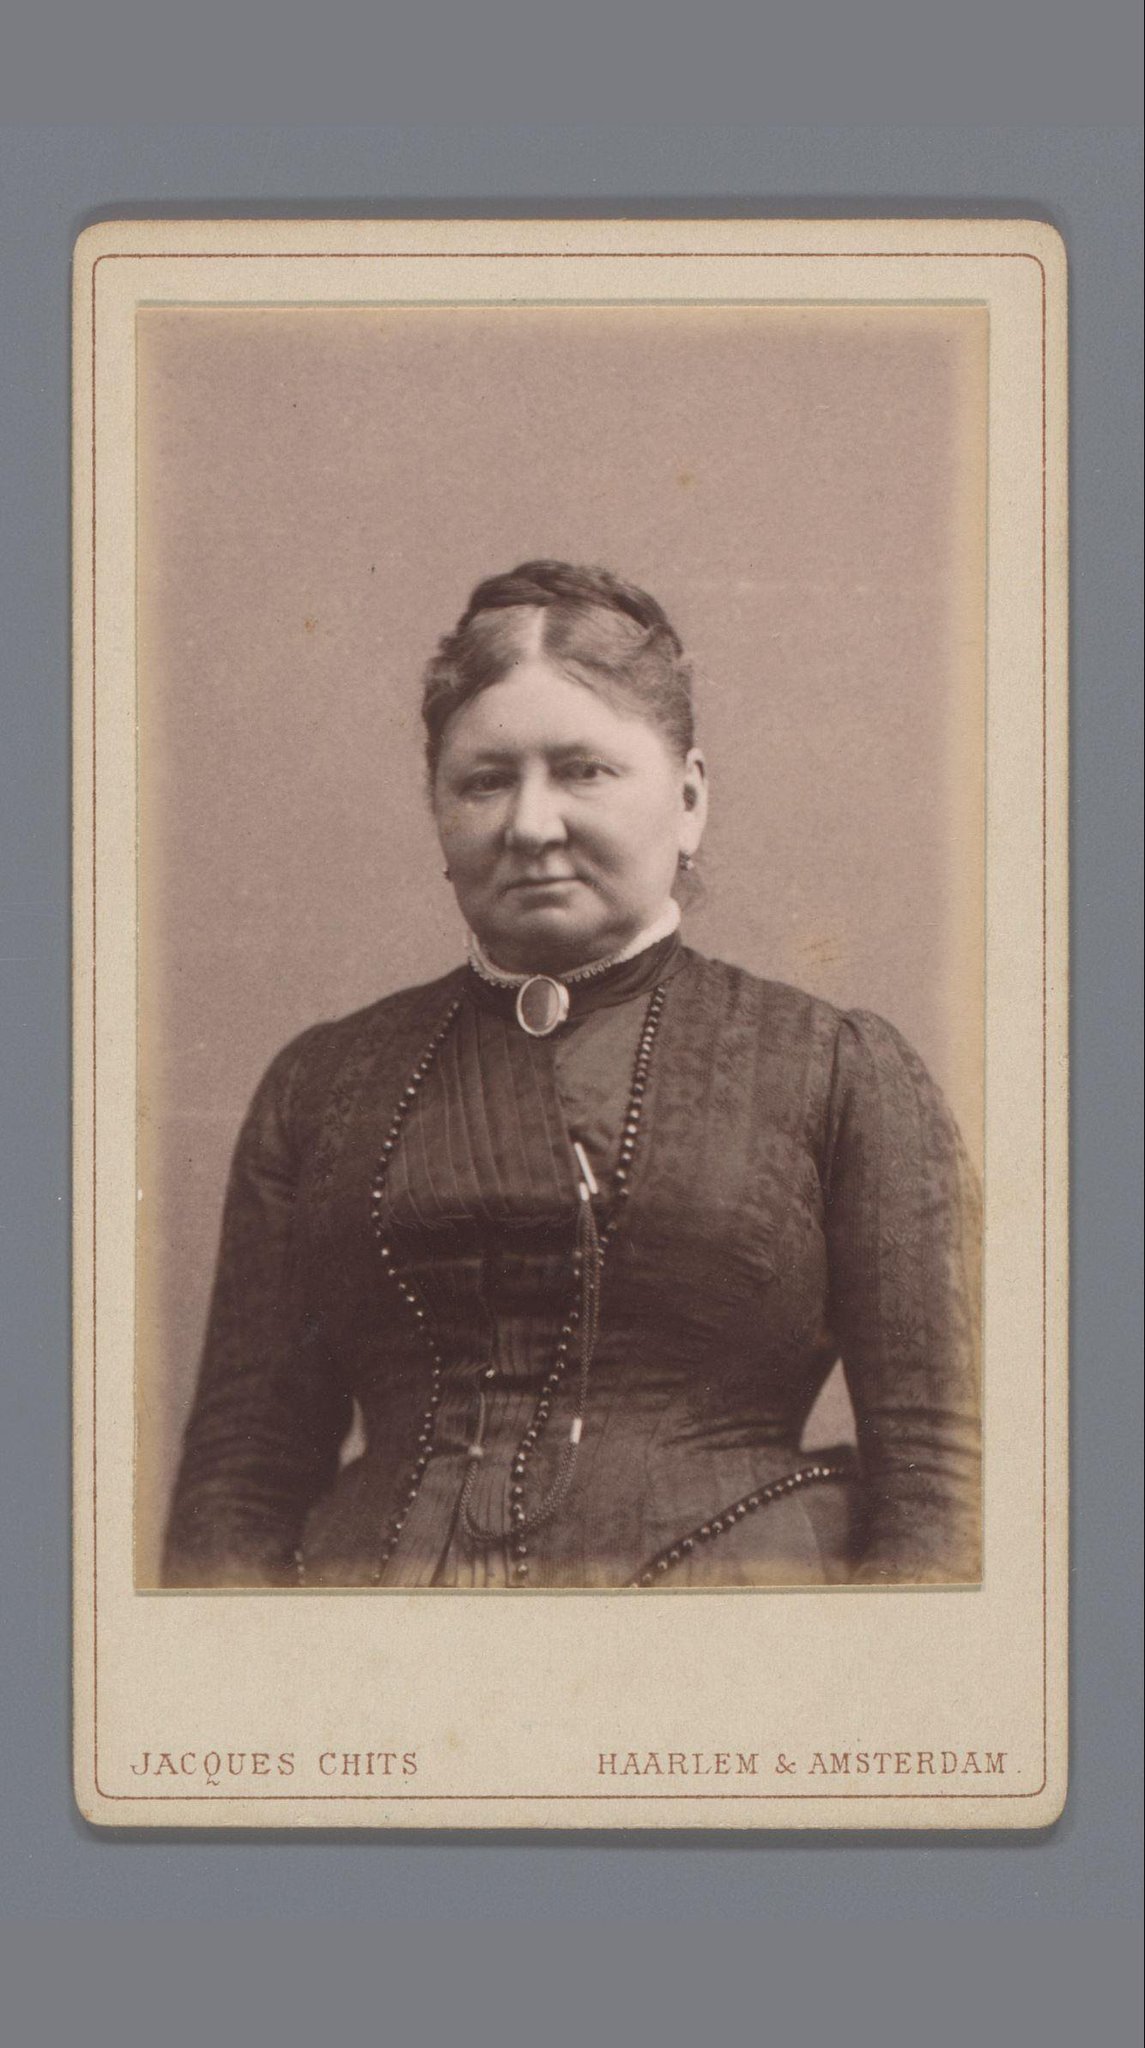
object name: photograph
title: Portret van een onbekende vrouw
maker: jacques chits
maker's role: fotograaf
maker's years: 1835-1917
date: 1881-1887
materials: paper, cardboard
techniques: collodion silver print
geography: haarlem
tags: adult woman, anonymous historical person portrayed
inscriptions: address: ‘Haarlem/ Waaigat/ No. 14./ Amsterdam/ Plantage/ Kerklaan No. 15/ over de Koningskroon.’, inscription: ‘De plaat blijft ter nabestelling bewaard.’